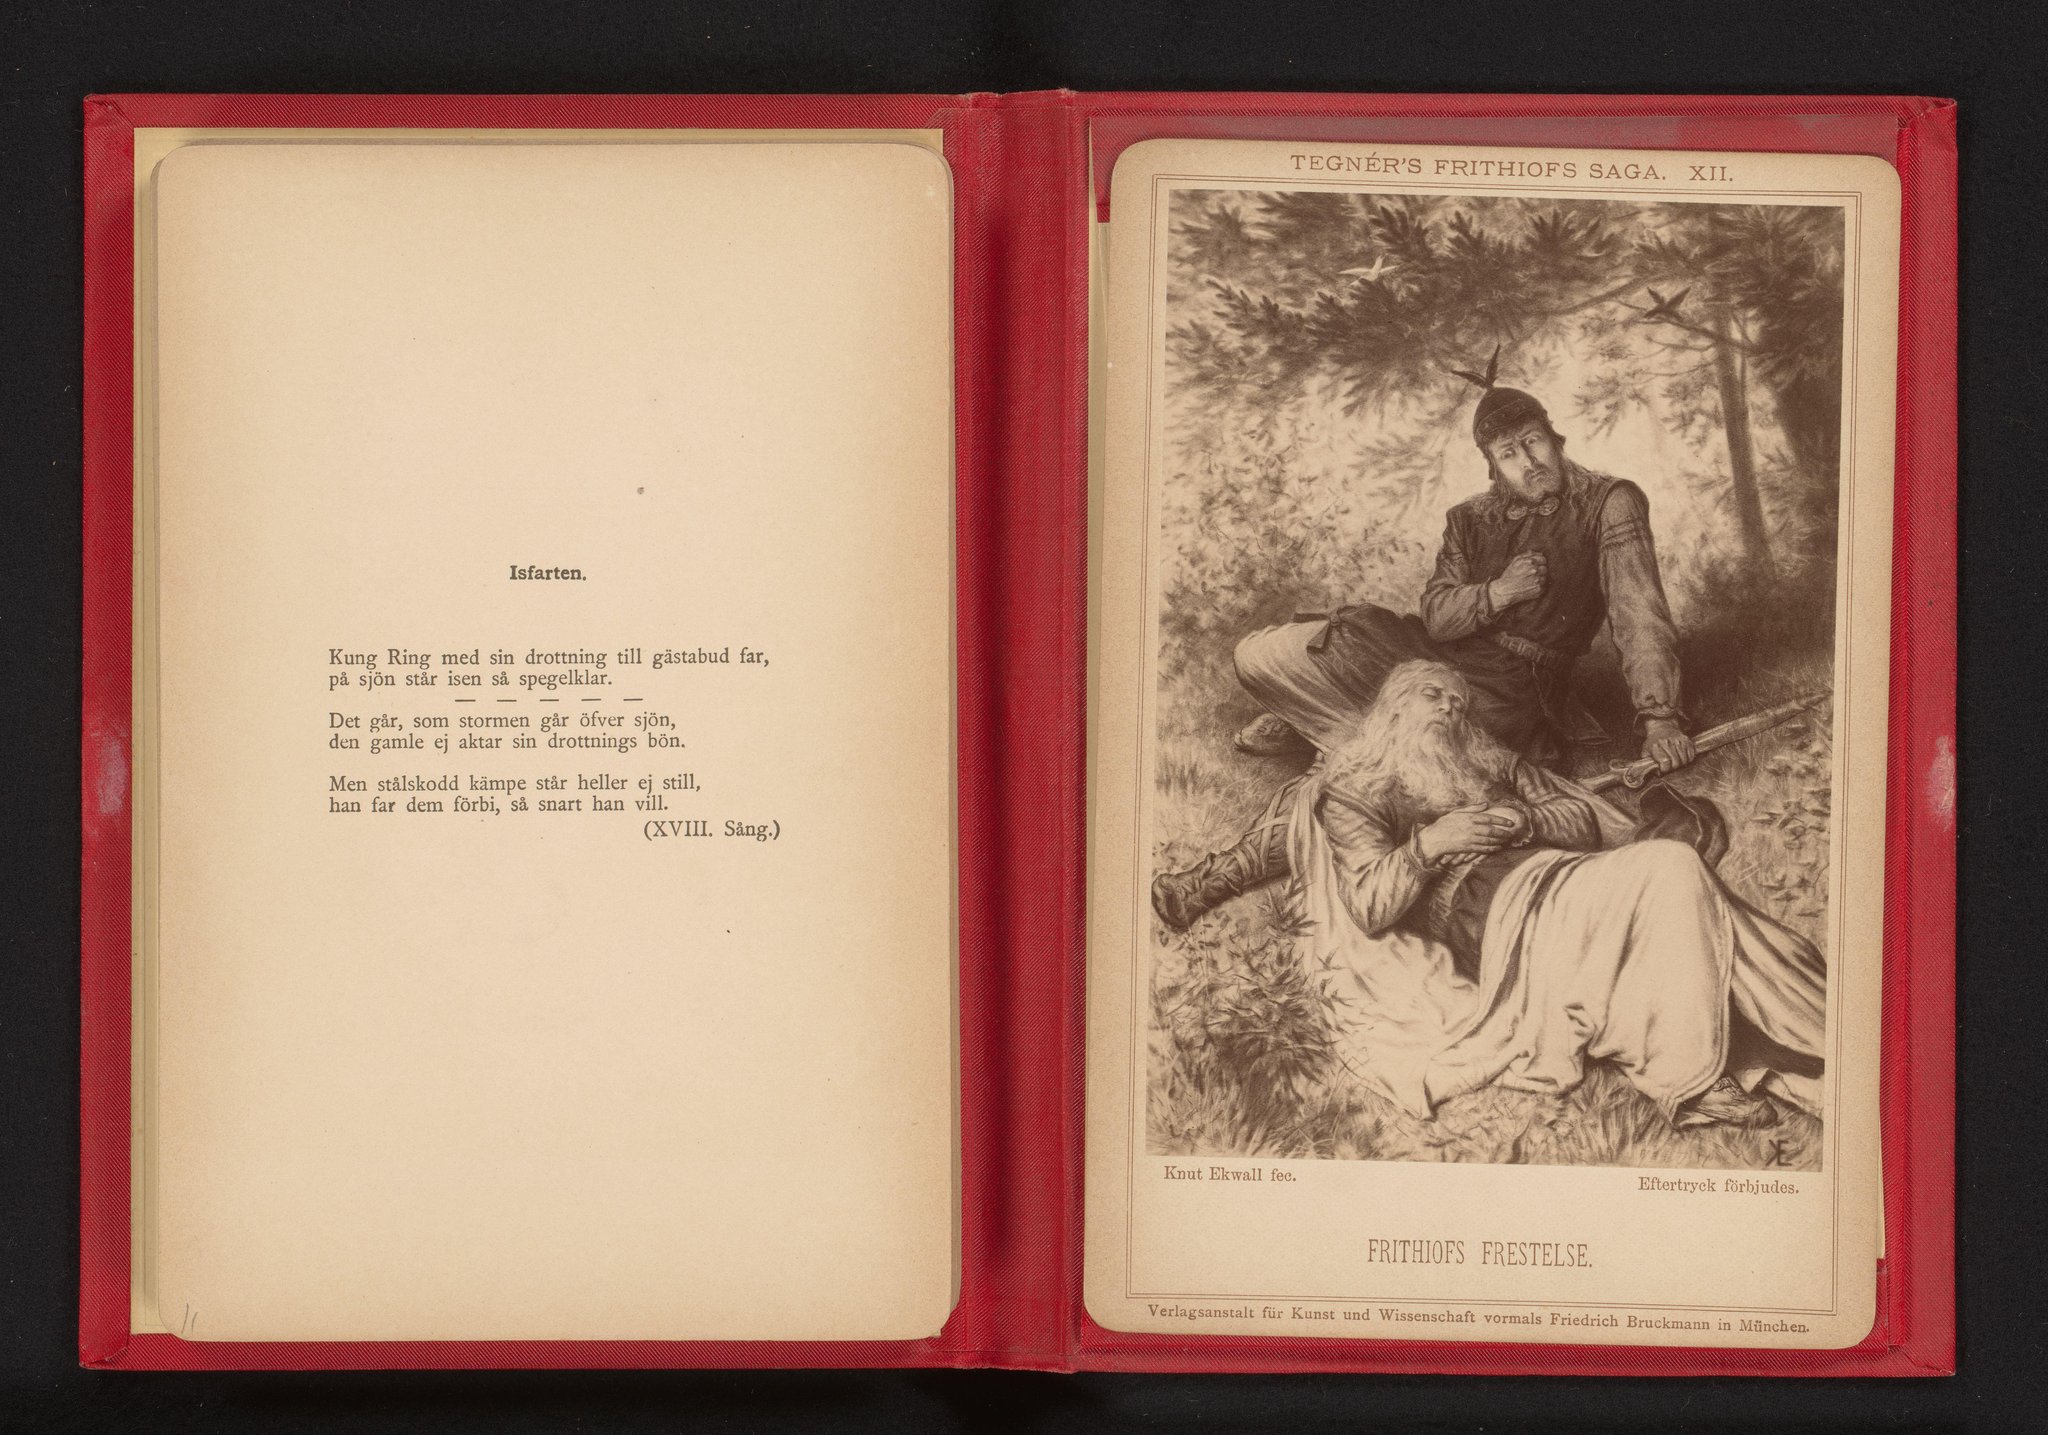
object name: page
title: Fotoreproductie van een schilderij, voorstellende Frithiof komt in de verleiding om koning Ring om te brengen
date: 1874-1884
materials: photographic support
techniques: albumen print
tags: ruler, sovereign, revolutionary action (violent)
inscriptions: number: ‘XII.’